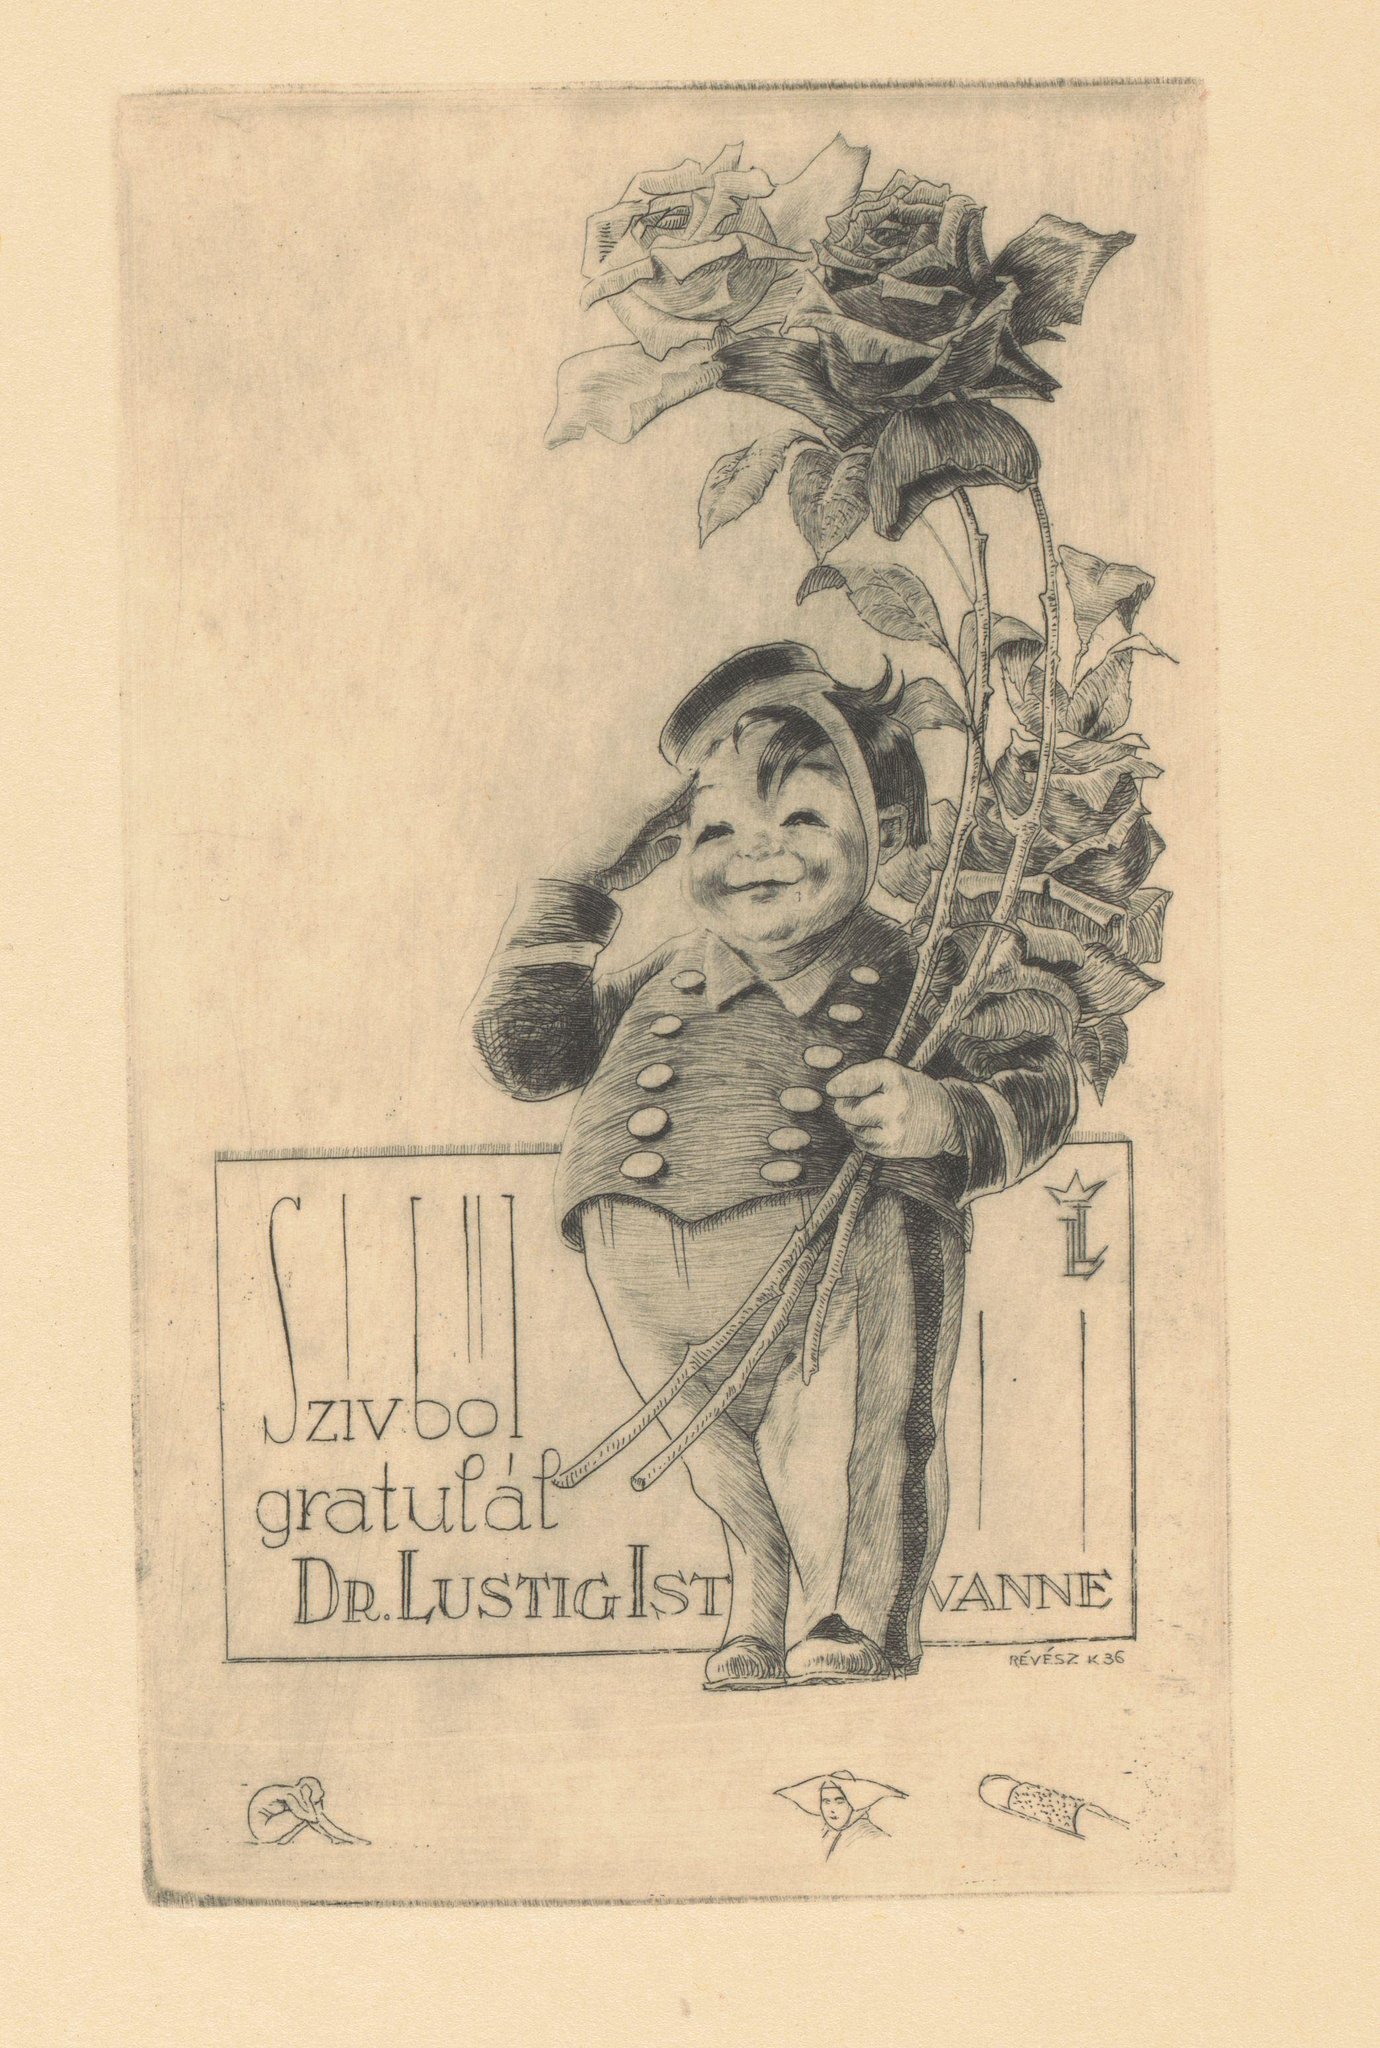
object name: gelegenheidsgrafiek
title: Szívböl gratulár dr. Lustig Istvánné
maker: kornél révész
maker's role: print maker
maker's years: 1885-1944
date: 1913-1936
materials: paper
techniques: drypoint, etching, intaglio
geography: hungary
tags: flowers: rose, military salutes, house personnel, servants, child between toddler and youth (of undetermined sex)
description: Prent is deel van een catalogus met 13 ingebonden objecten en twee tekstbladen. Catalogus is deel van een omslag met 64 objecten op 34 opzetvellen en een tekstblad.